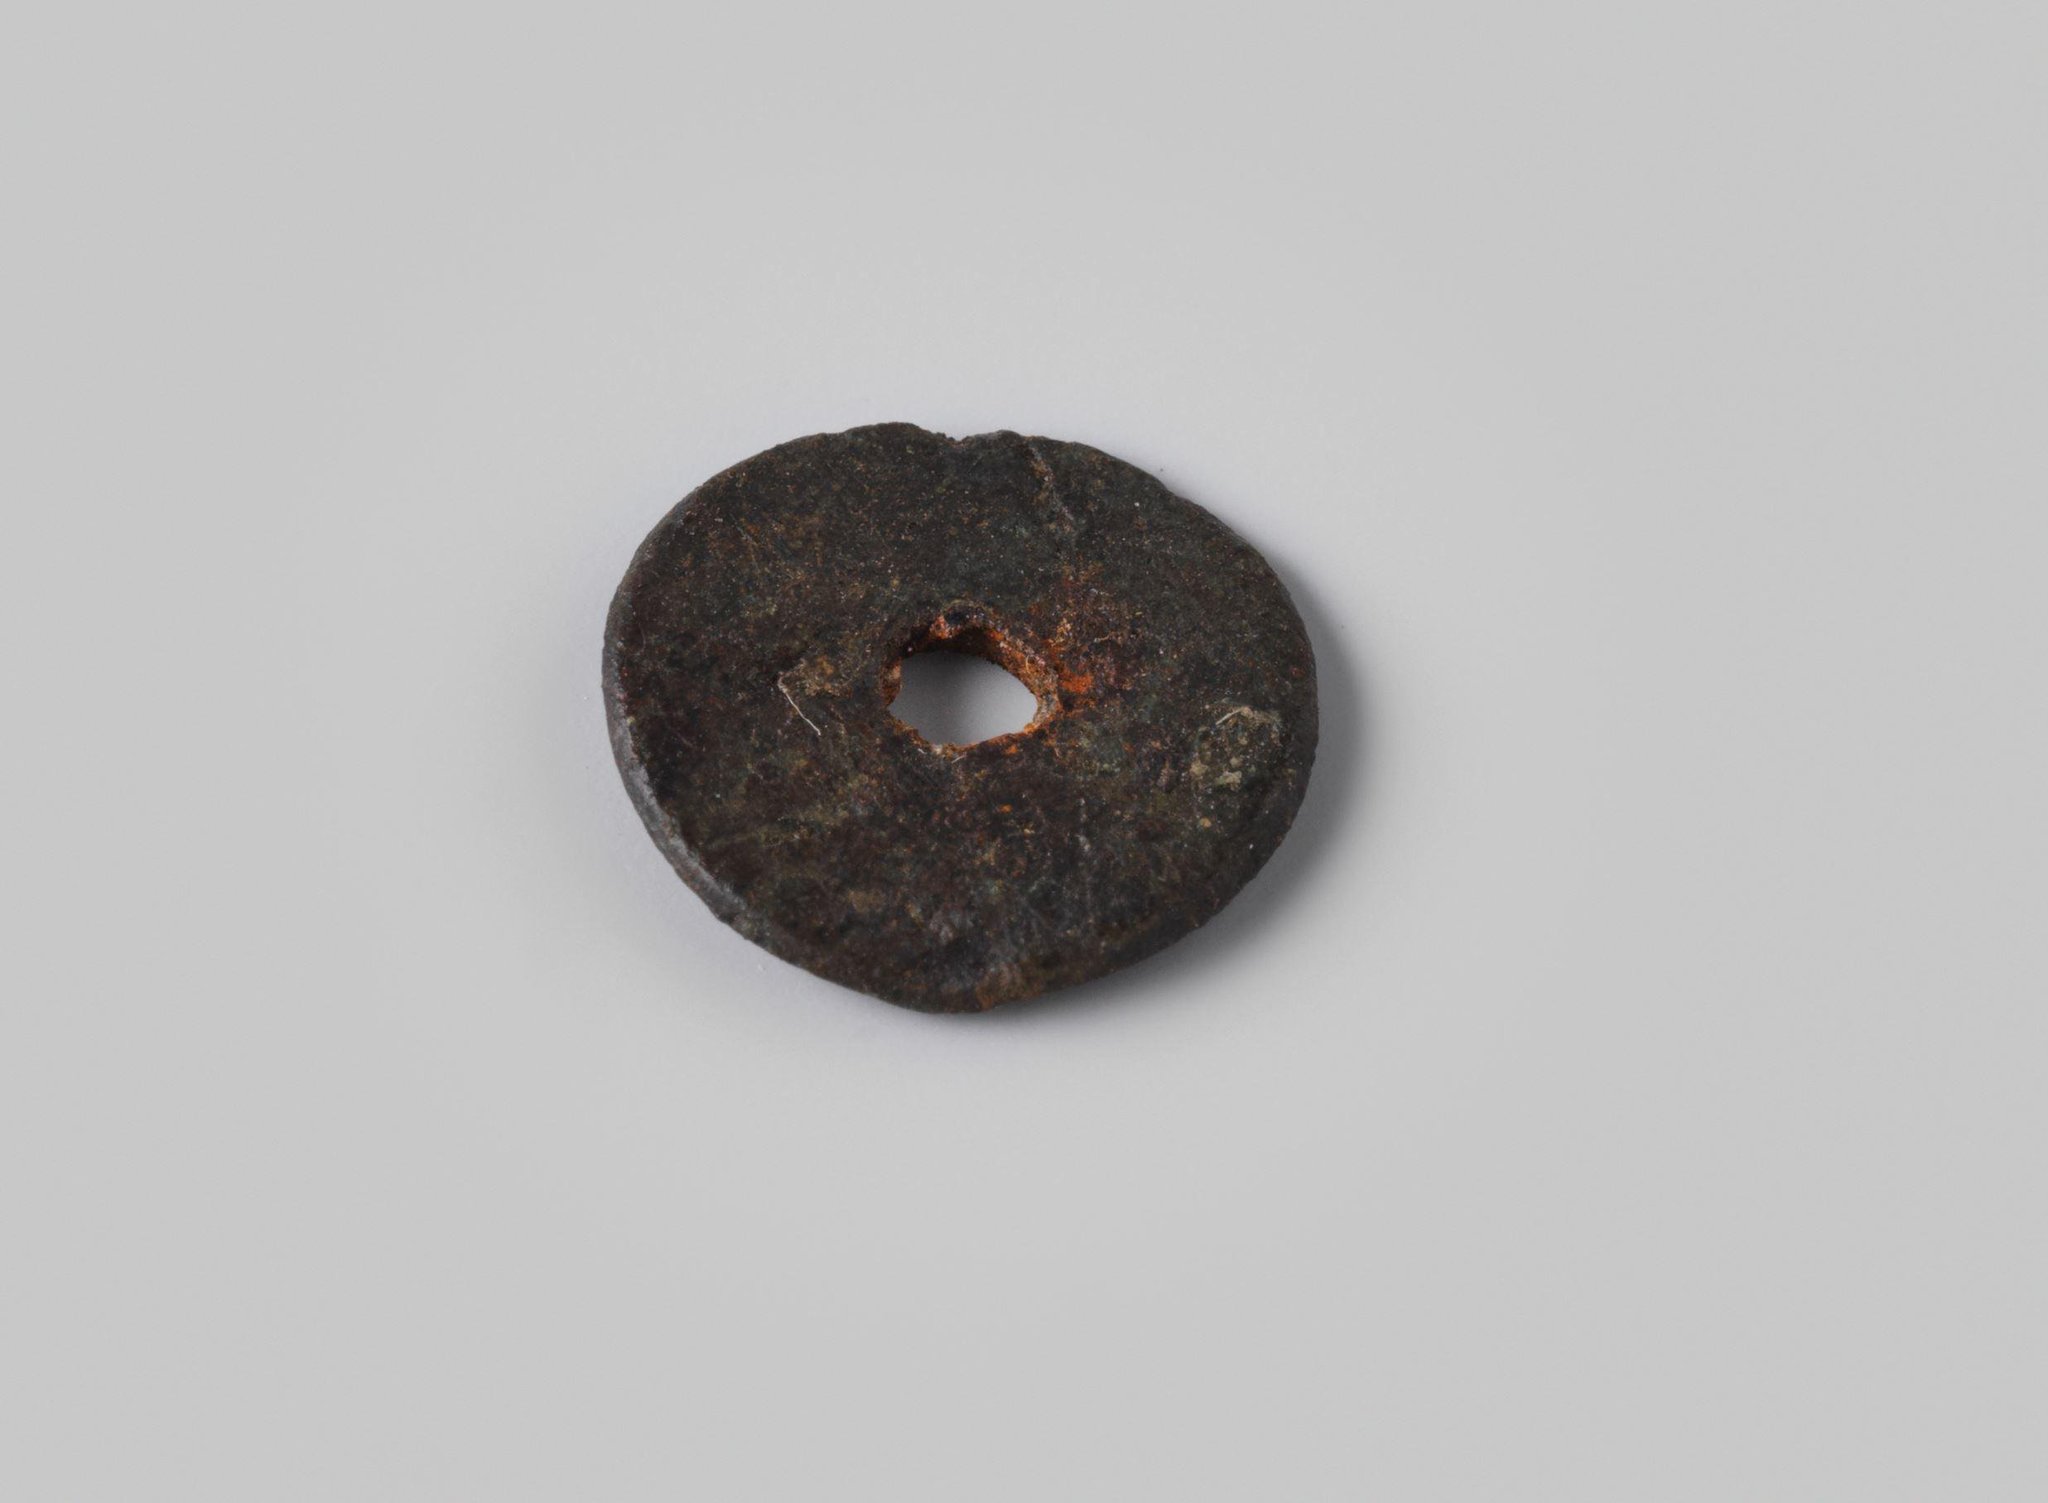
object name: sluitring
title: Sluitring uit het wrak van de Oost-Indiëvaarder Hollandia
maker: Anonymous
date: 1700-1743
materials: copper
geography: netherlands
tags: verenigde oostindische compagnie, hollandia (schip), annet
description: Varied parts or fragments, washers; id. 80H3039.